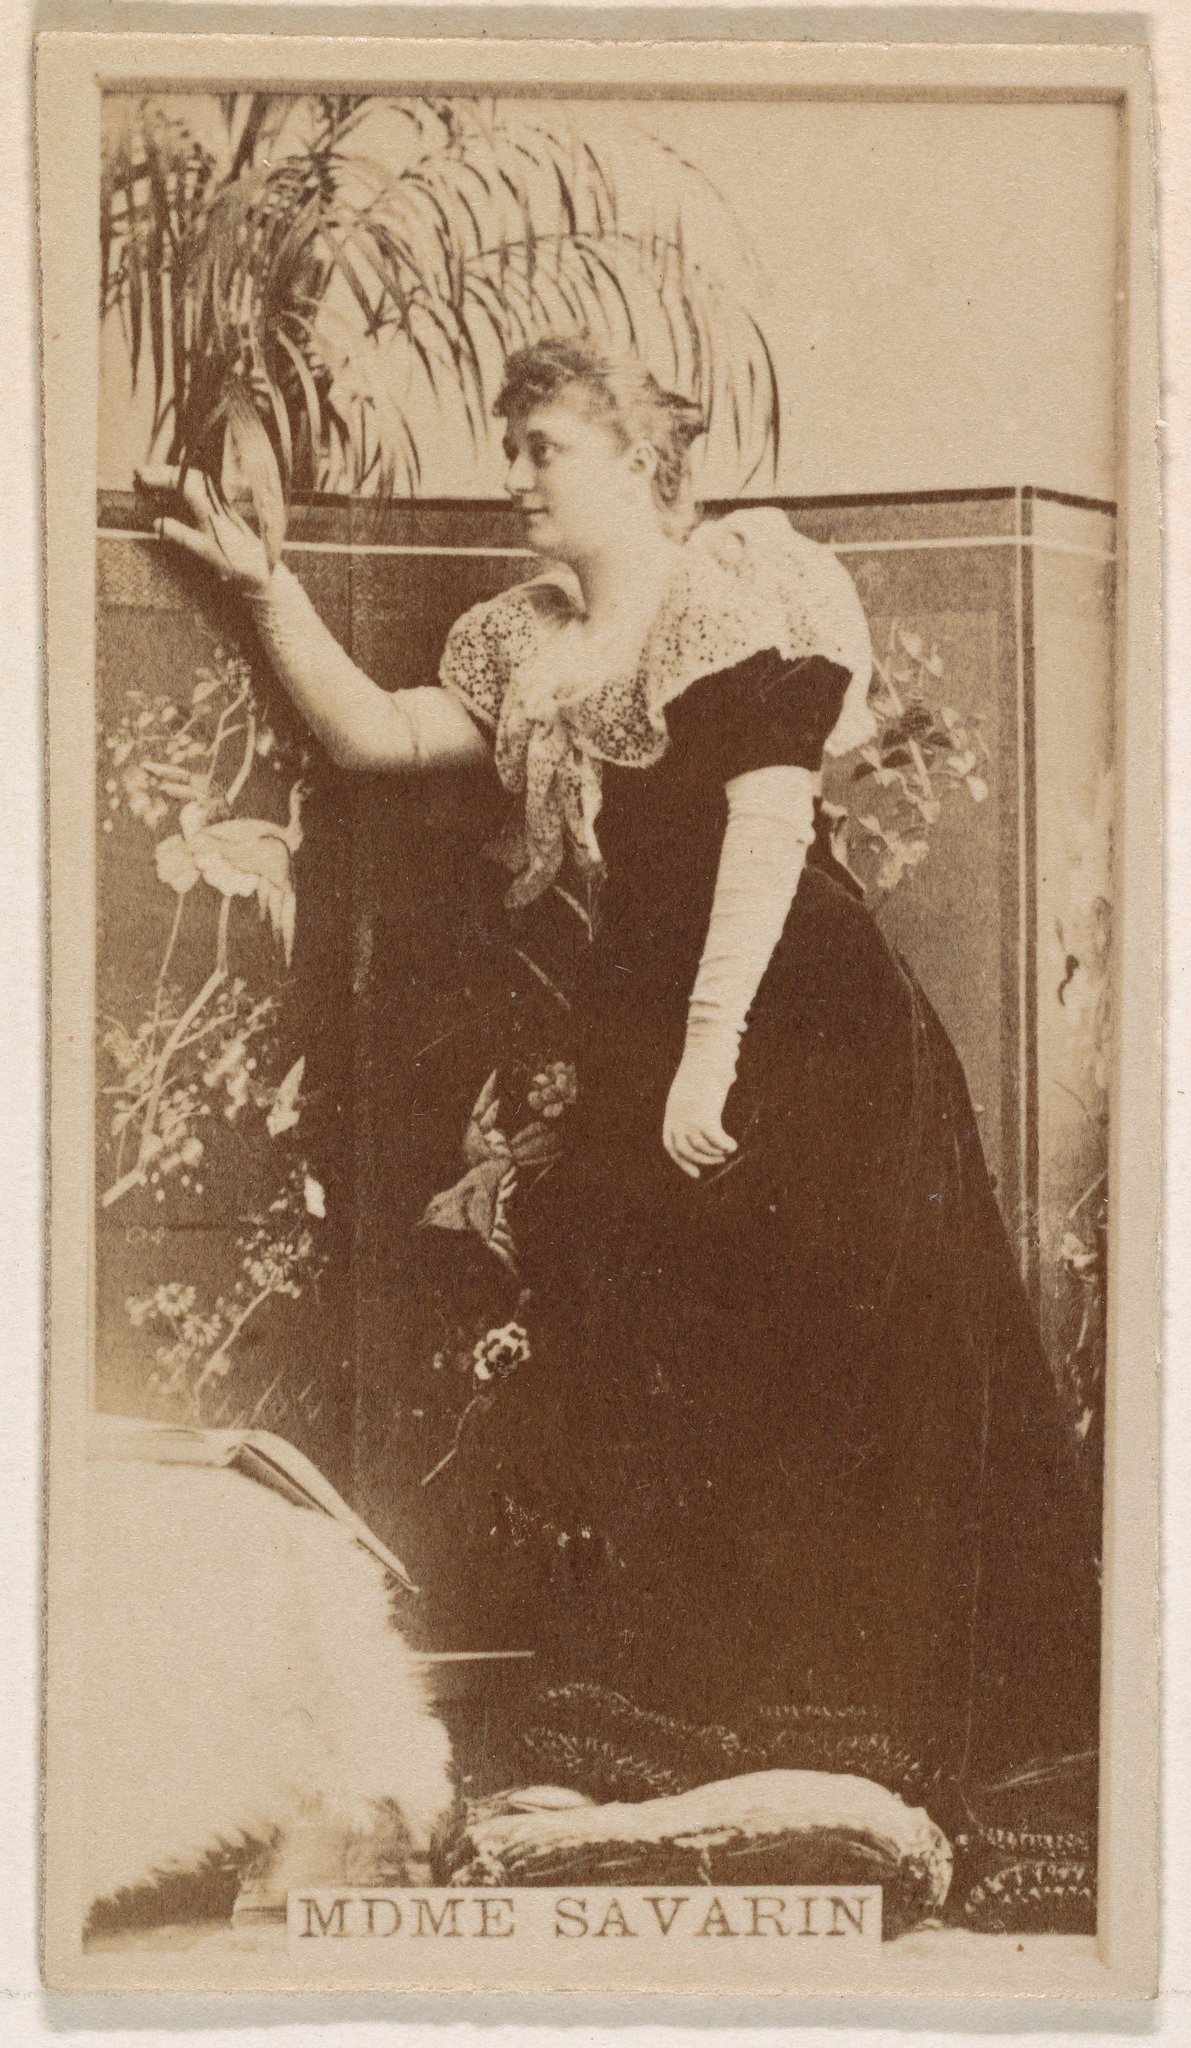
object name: photograph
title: Mdme Savarin, from the Actresses series (N245) issued by Kinney Brothers to promote Sweet Caporal Cigarettes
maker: kinney brothers tobacco company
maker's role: publisher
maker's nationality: american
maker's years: 1869-2011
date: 1890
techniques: albumen silver print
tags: women,actresses